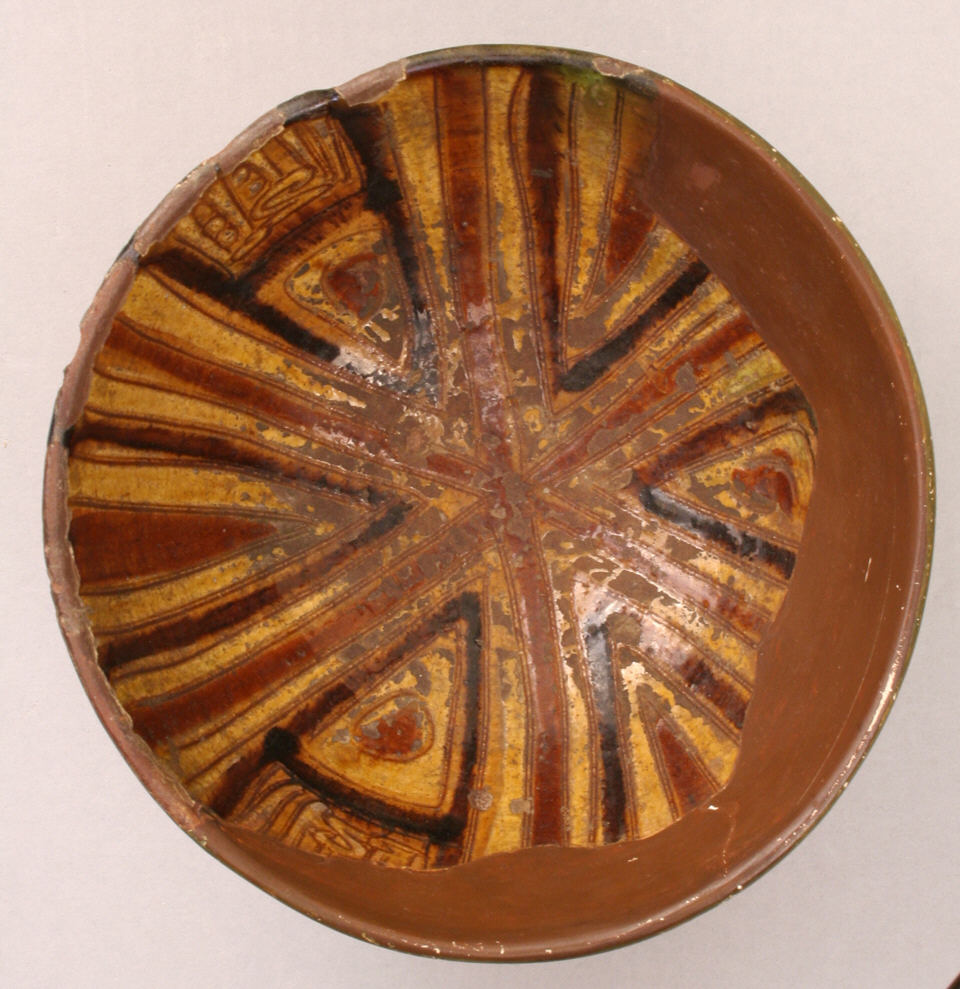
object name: fragment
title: Fragment of a Bowl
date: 1301-1500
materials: earthenware, glaze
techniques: coloring, incising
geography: egypt